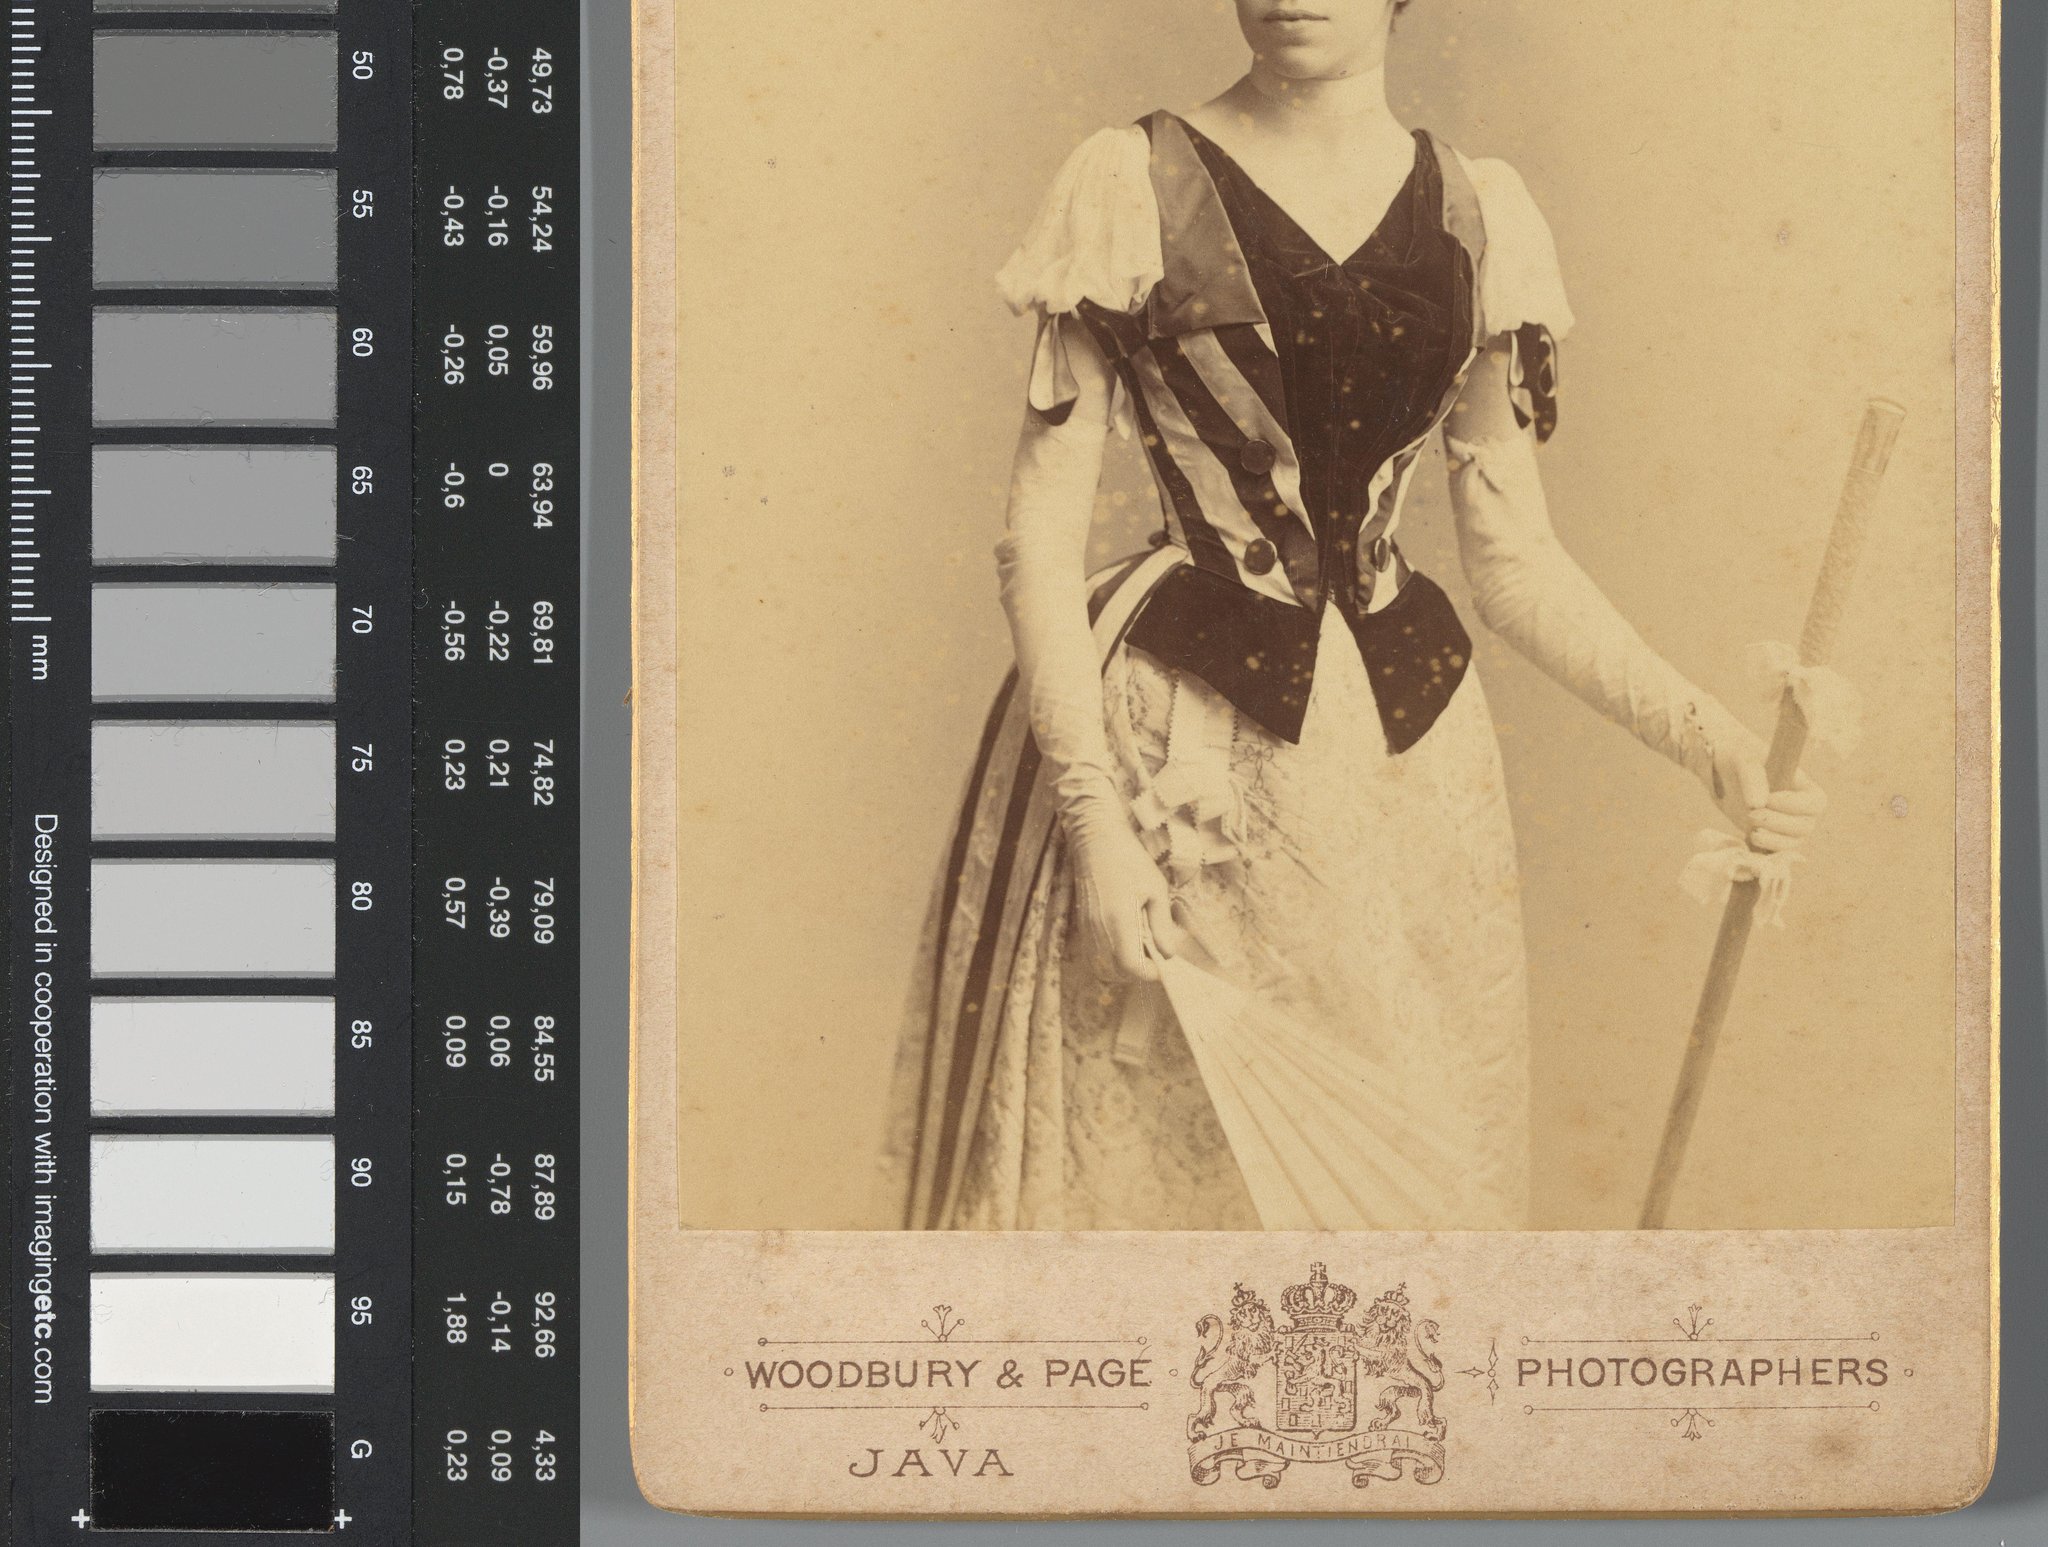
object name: cabinet photograph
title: Studioportret van Emilie van den Berg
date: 1885-1900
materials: cardboard, photographic support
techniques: albumen print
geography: java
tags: batavia, emilie albertine onnen-van den berg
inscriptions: name: ‘WOODBURY & PAGE / PHOTOGRAPHERS / JAVA.’, name: ‘Emilie A. van den Berg’, name: ‘WOODBURY & PAGE PHOTOGRAPHERS / JAVA’, name: ‘WOODBURY & PAGE , / JAVA.’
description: Studioportret van Emilie van den Berg, staand met hoed met struisveren en een waaier in haar rechter- en een stok in haar linkerhand.